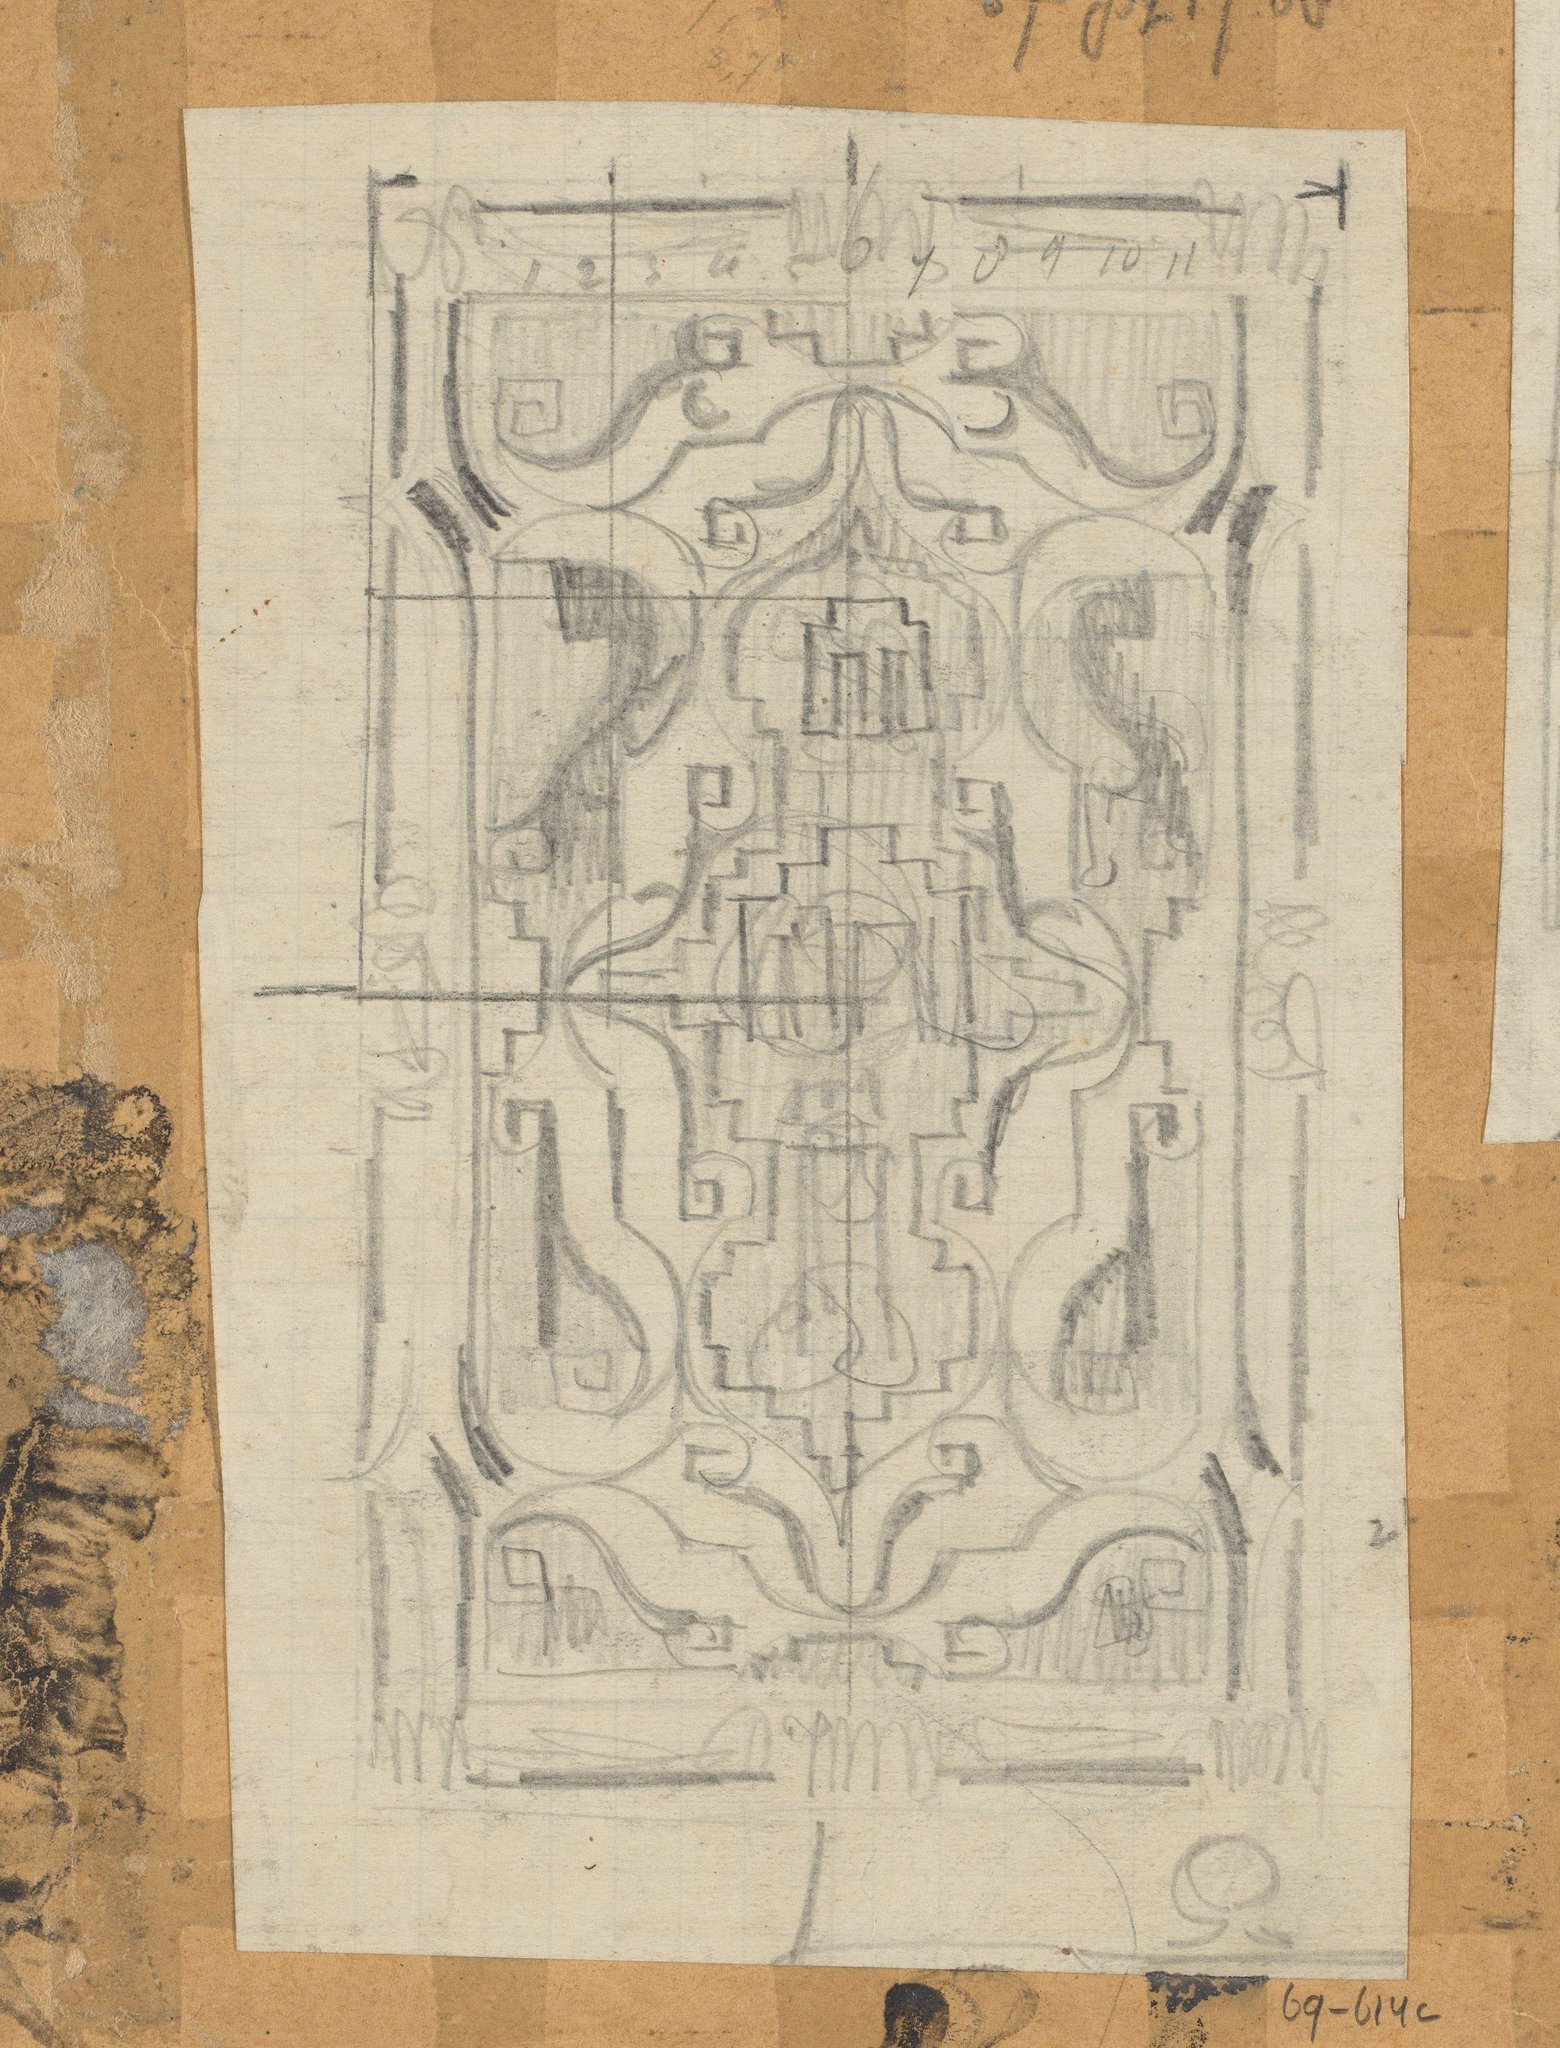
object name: design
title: Decoratief ontwerp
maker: carel adolph lion cachet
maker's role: draughtsman, print maker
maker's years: 1864-1945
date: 1874-1945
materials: pencil